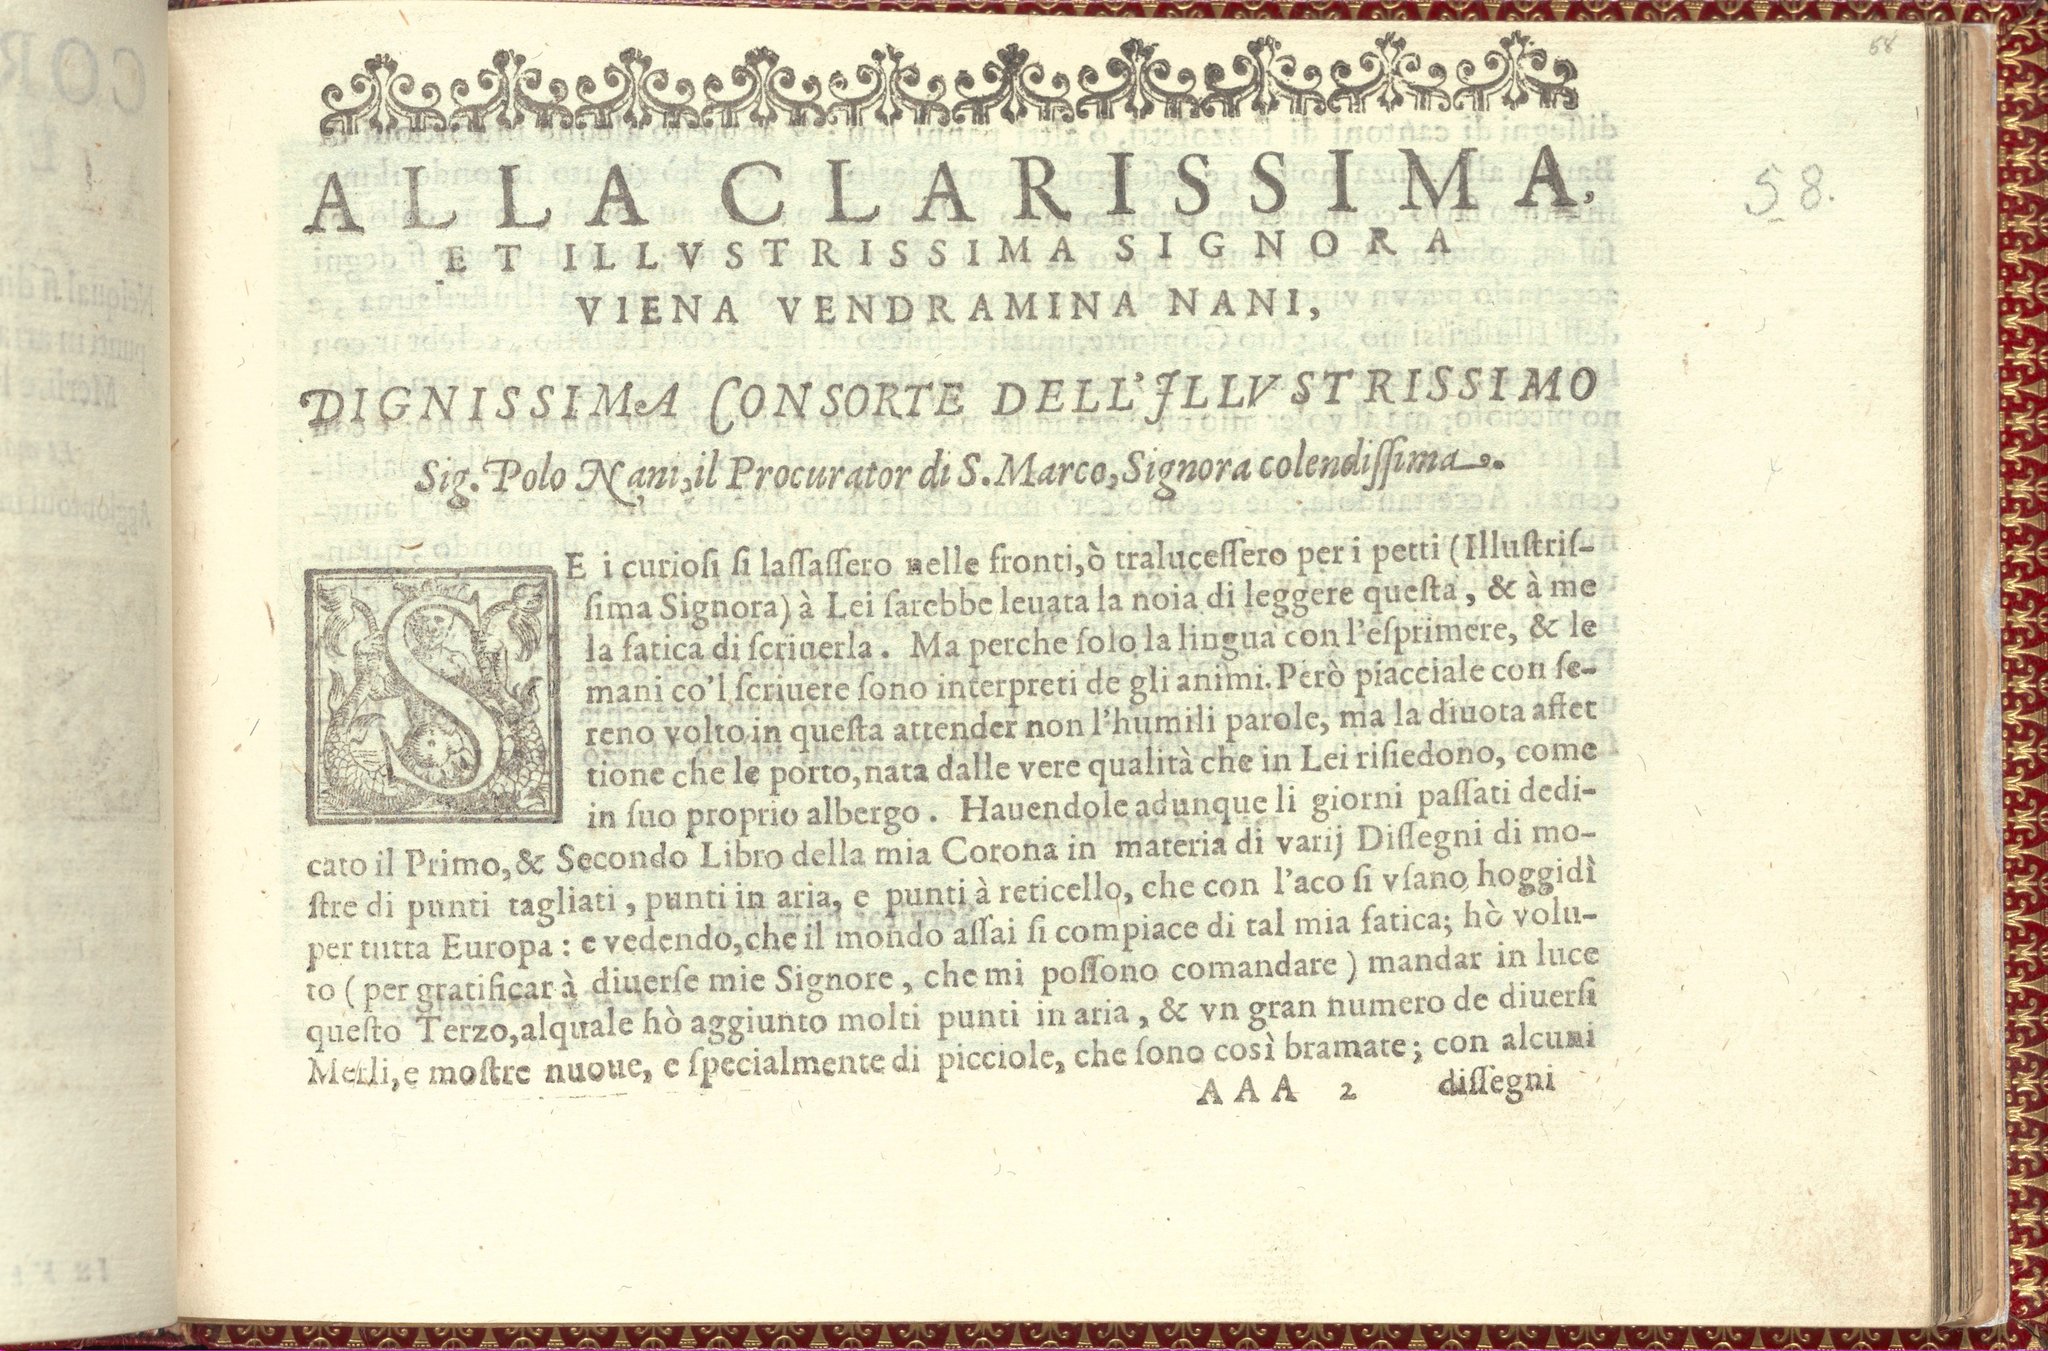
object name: book print ornament architecture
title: Corona delle Nobili et Virtuose Donne: Libro I-IV, page 58 (recto)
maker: cesare vecellio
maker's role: publisher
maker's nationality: italian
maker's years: 1521-1601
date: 1601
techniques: woodcut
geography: italy